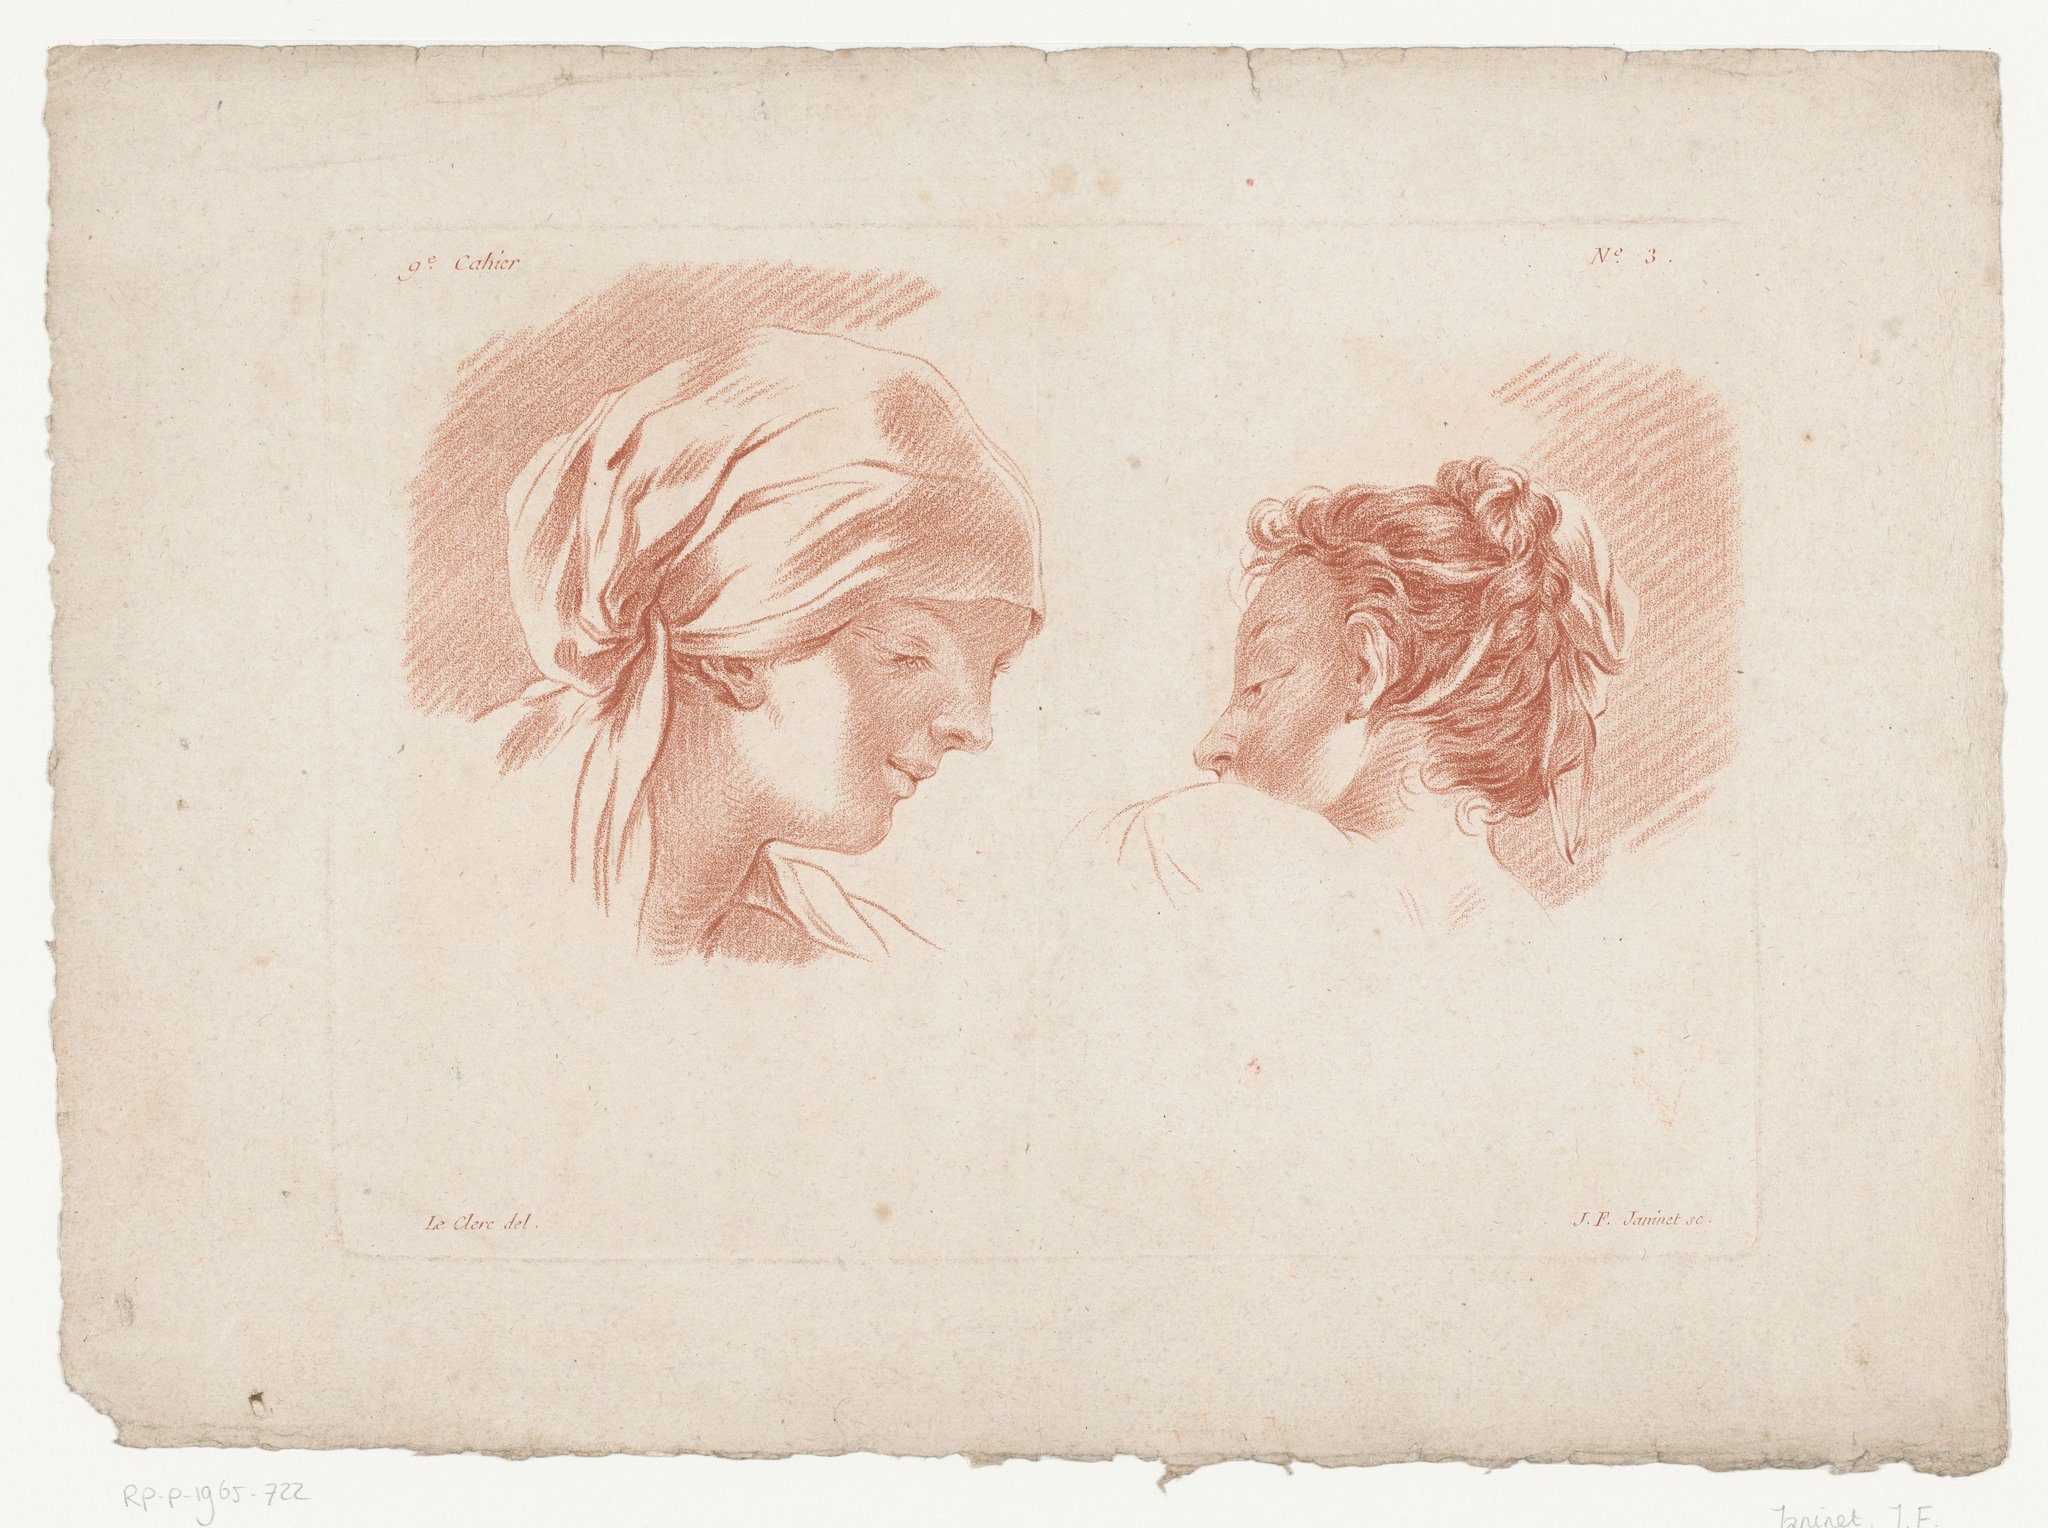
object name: print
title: IXe Cahier de Principes du Dessin d'après nature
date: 1773-1777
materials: paper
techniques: printmaking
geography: paris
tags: head (human) - aa - female human figure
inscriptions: collector's mark: Lugt 2228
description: Deze prent maakt deel uit van een album dat uit minstens elf delen bestaat. Waarschijnlijk dienden deze albums als voorbeeld voor tekenaars, schilders en graveurs.